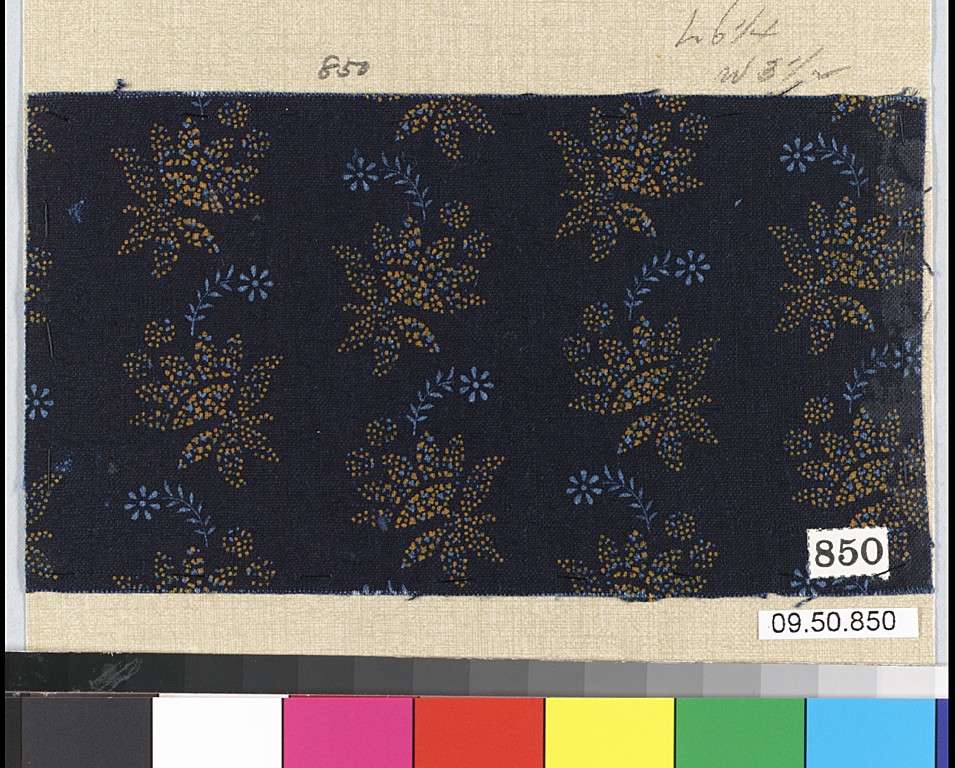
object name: piece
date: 1801-1900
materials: cotton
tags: flowers,leaves